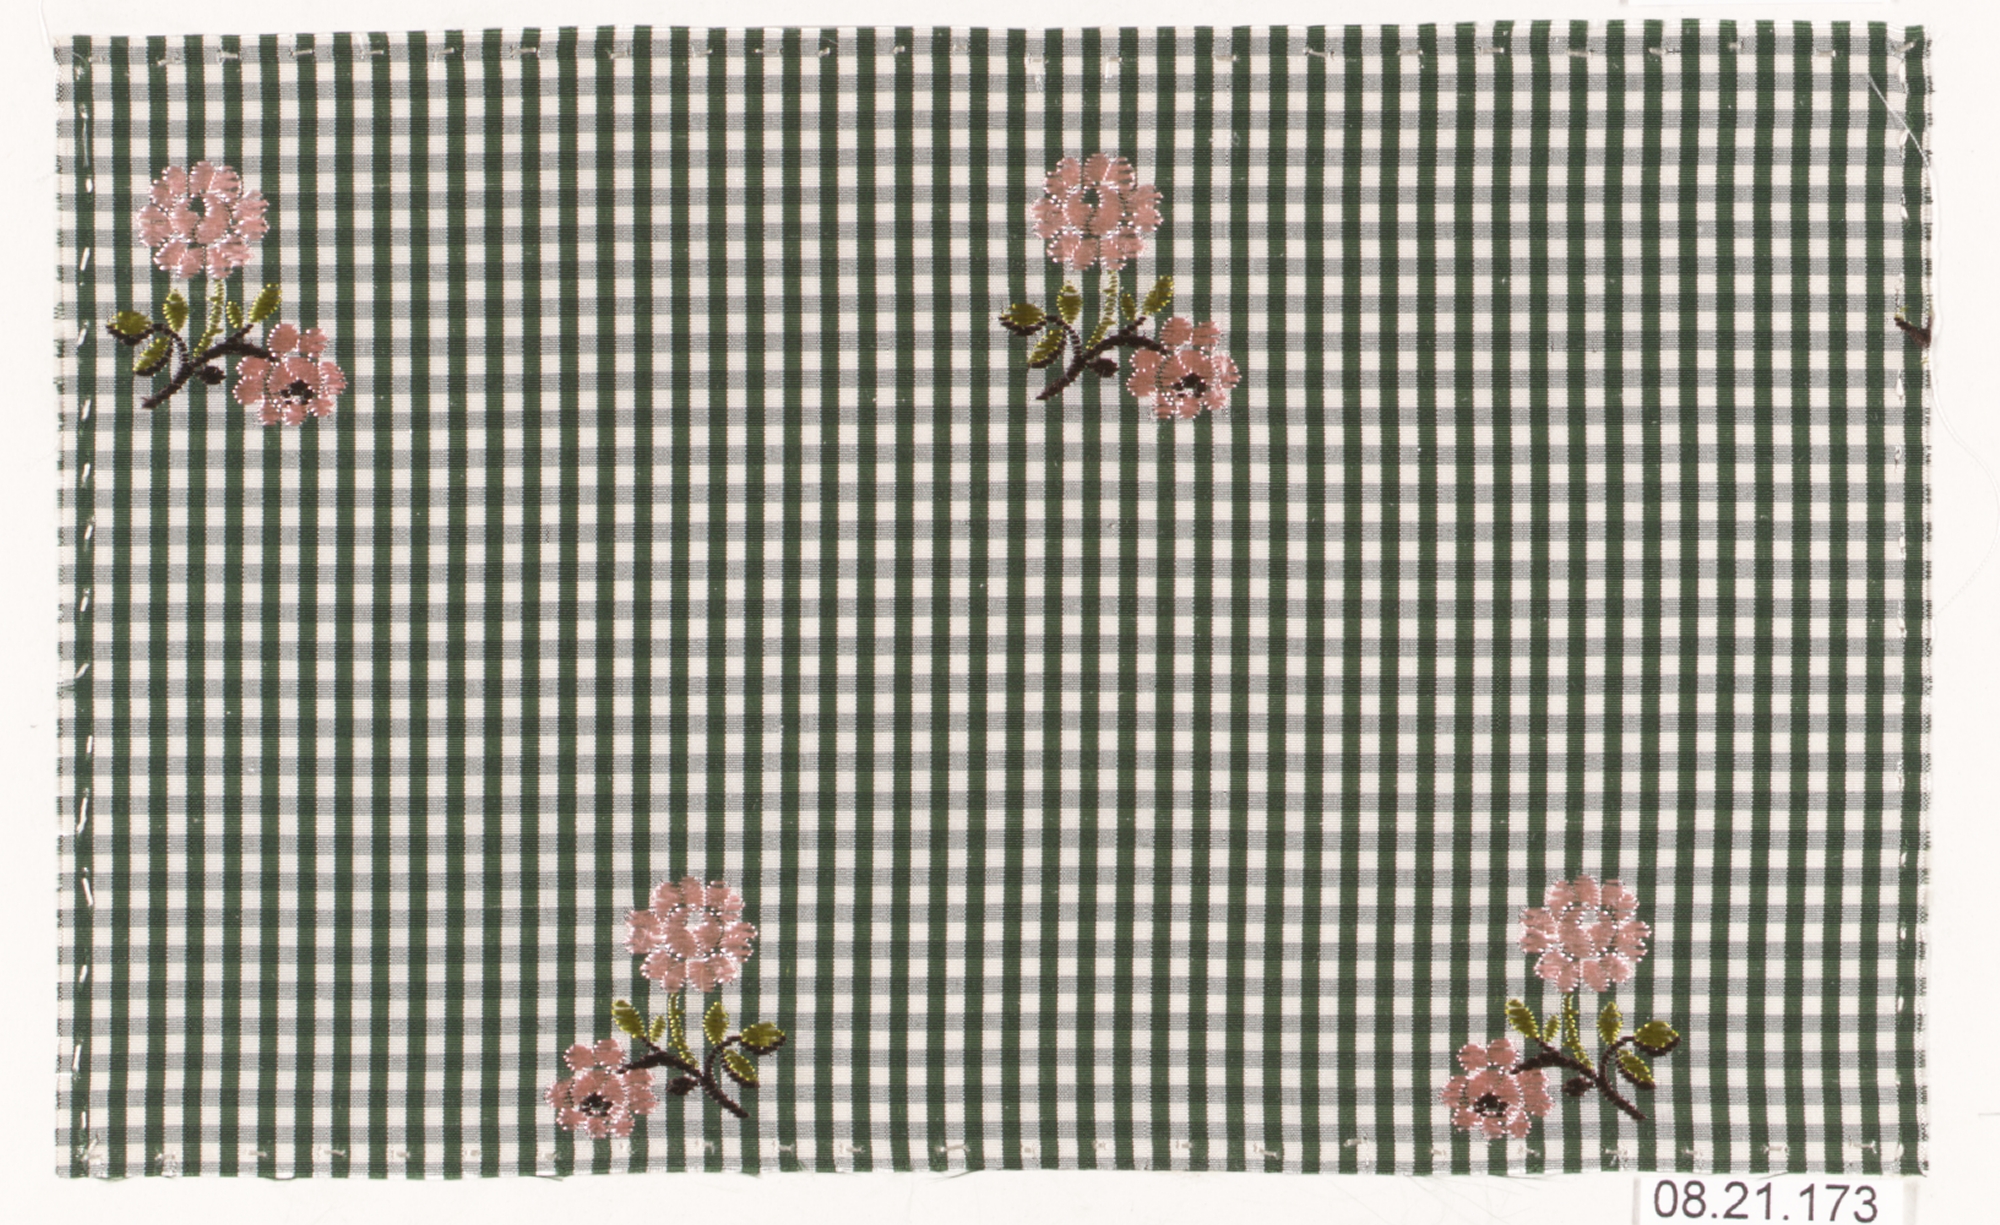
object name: textile sample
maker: Anonymous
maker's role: designer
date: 1900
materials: silk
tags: flowers